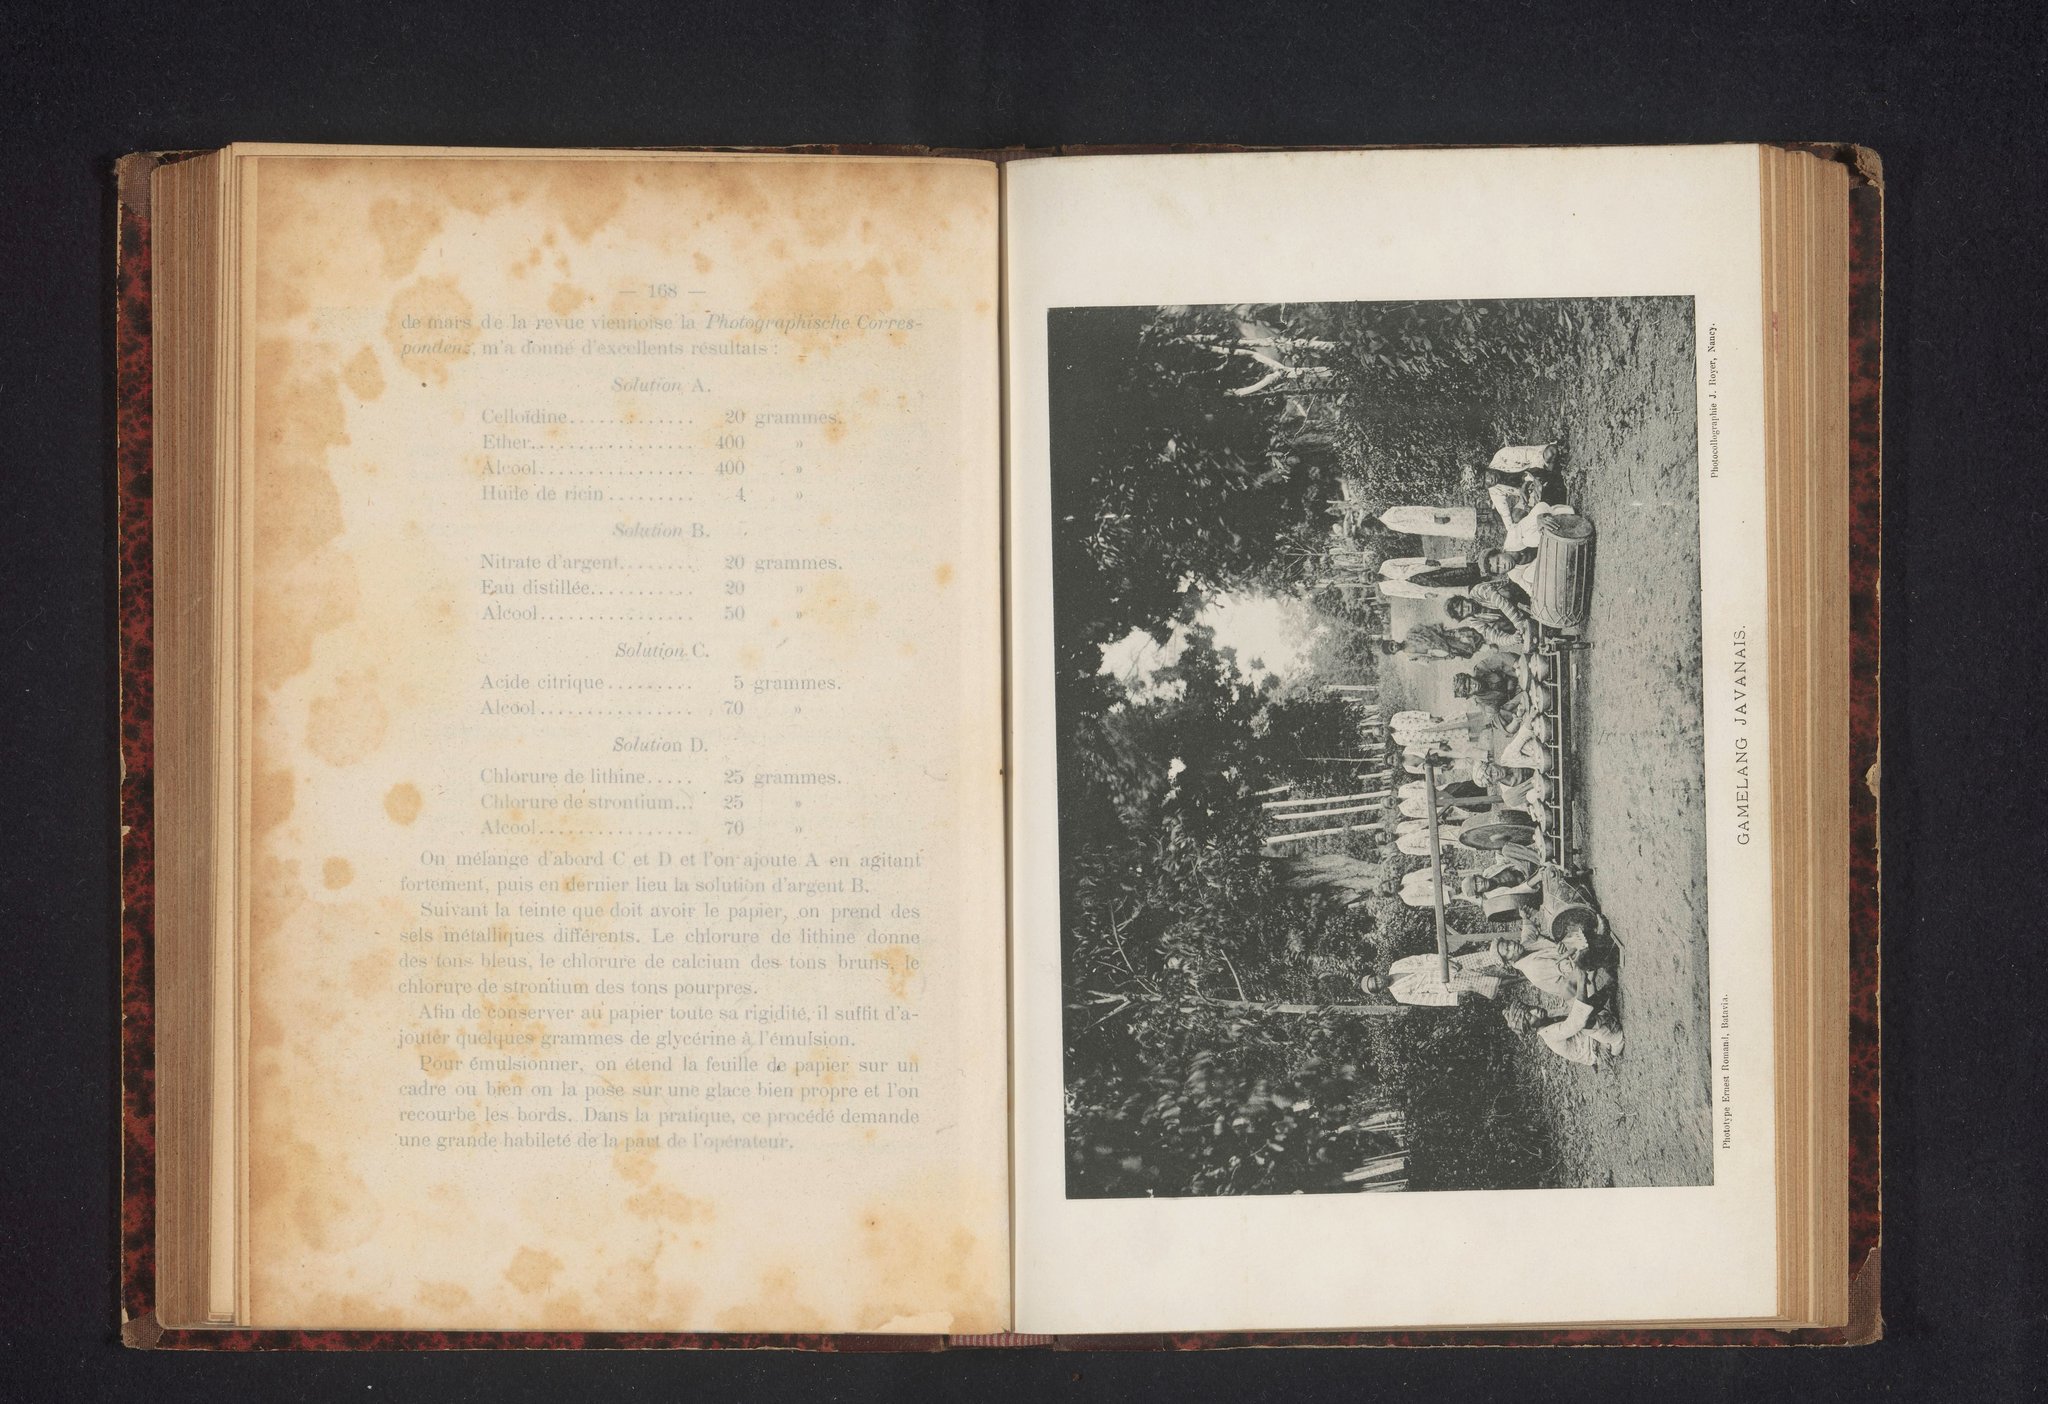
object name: photomechanical print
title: Gamelan poserend op een landweg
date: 1889-1894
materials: paper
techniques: photograph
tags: more than one musician with instrument, anonymous historical persons portrayed in a group, in a group-portrait